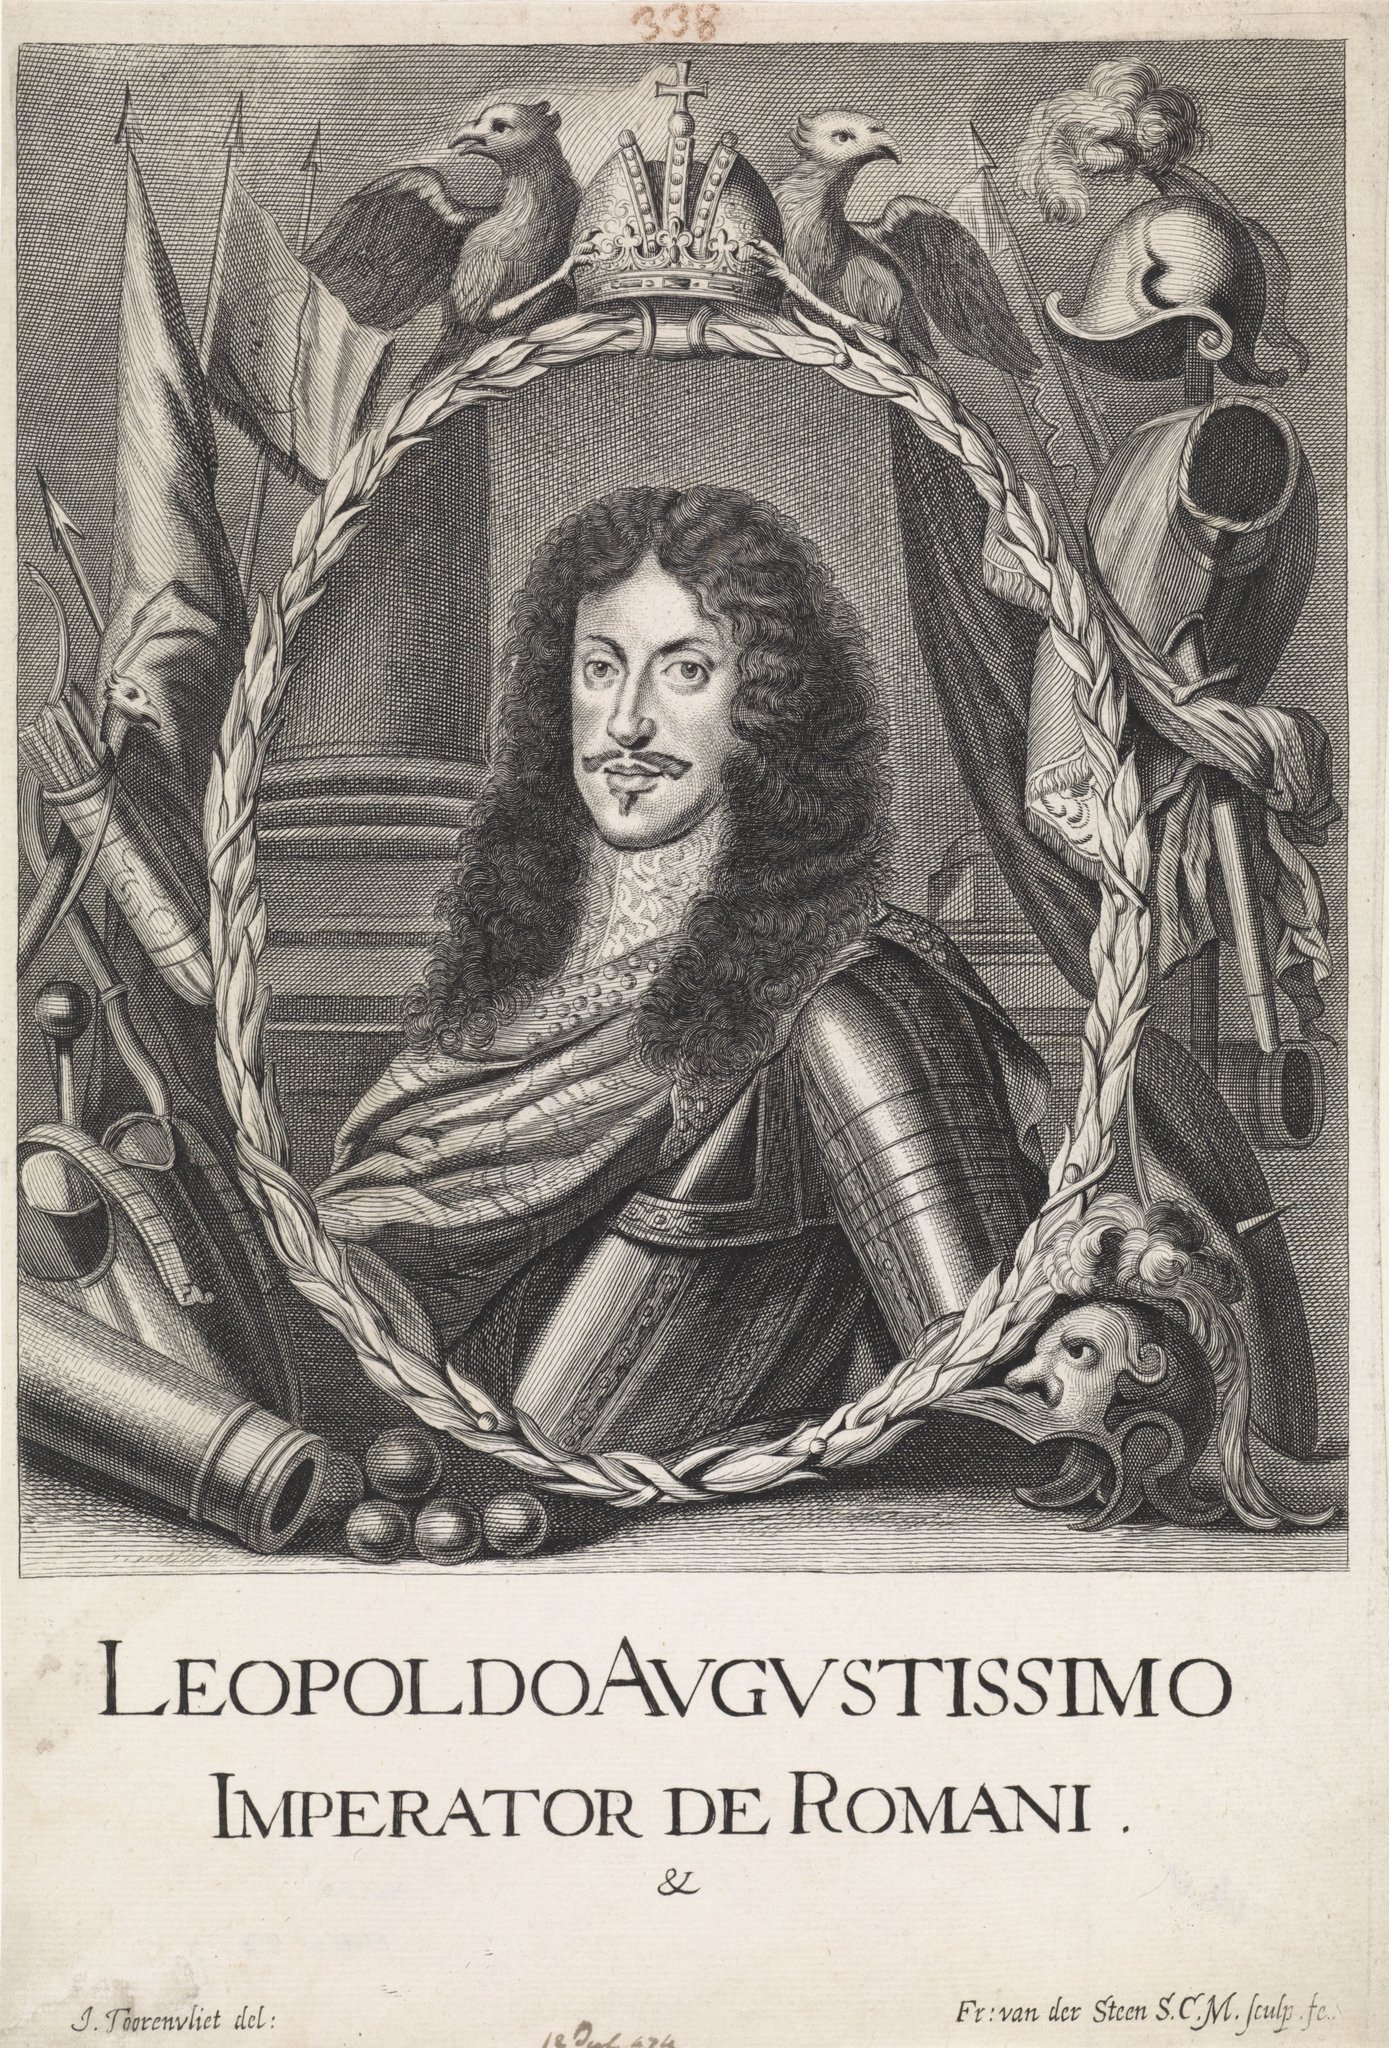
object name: print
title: Portret van keizer Leopold I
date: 1670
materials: paper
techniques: engraving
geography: vienna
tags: leopold i (keizer van duitsland), weapons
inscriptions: collector's mark: Lugt 2228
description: Portret van Leopold I, Rooms-Duits keizer, gekleed in harnas, in een omlijsting van laurierbladeren. De lijst wordt bekroond door twee adelaars met de keizerskroon. Rond de lijst wapentuig. Onderaan in de marge zijn naam en functie in het Italiaans.